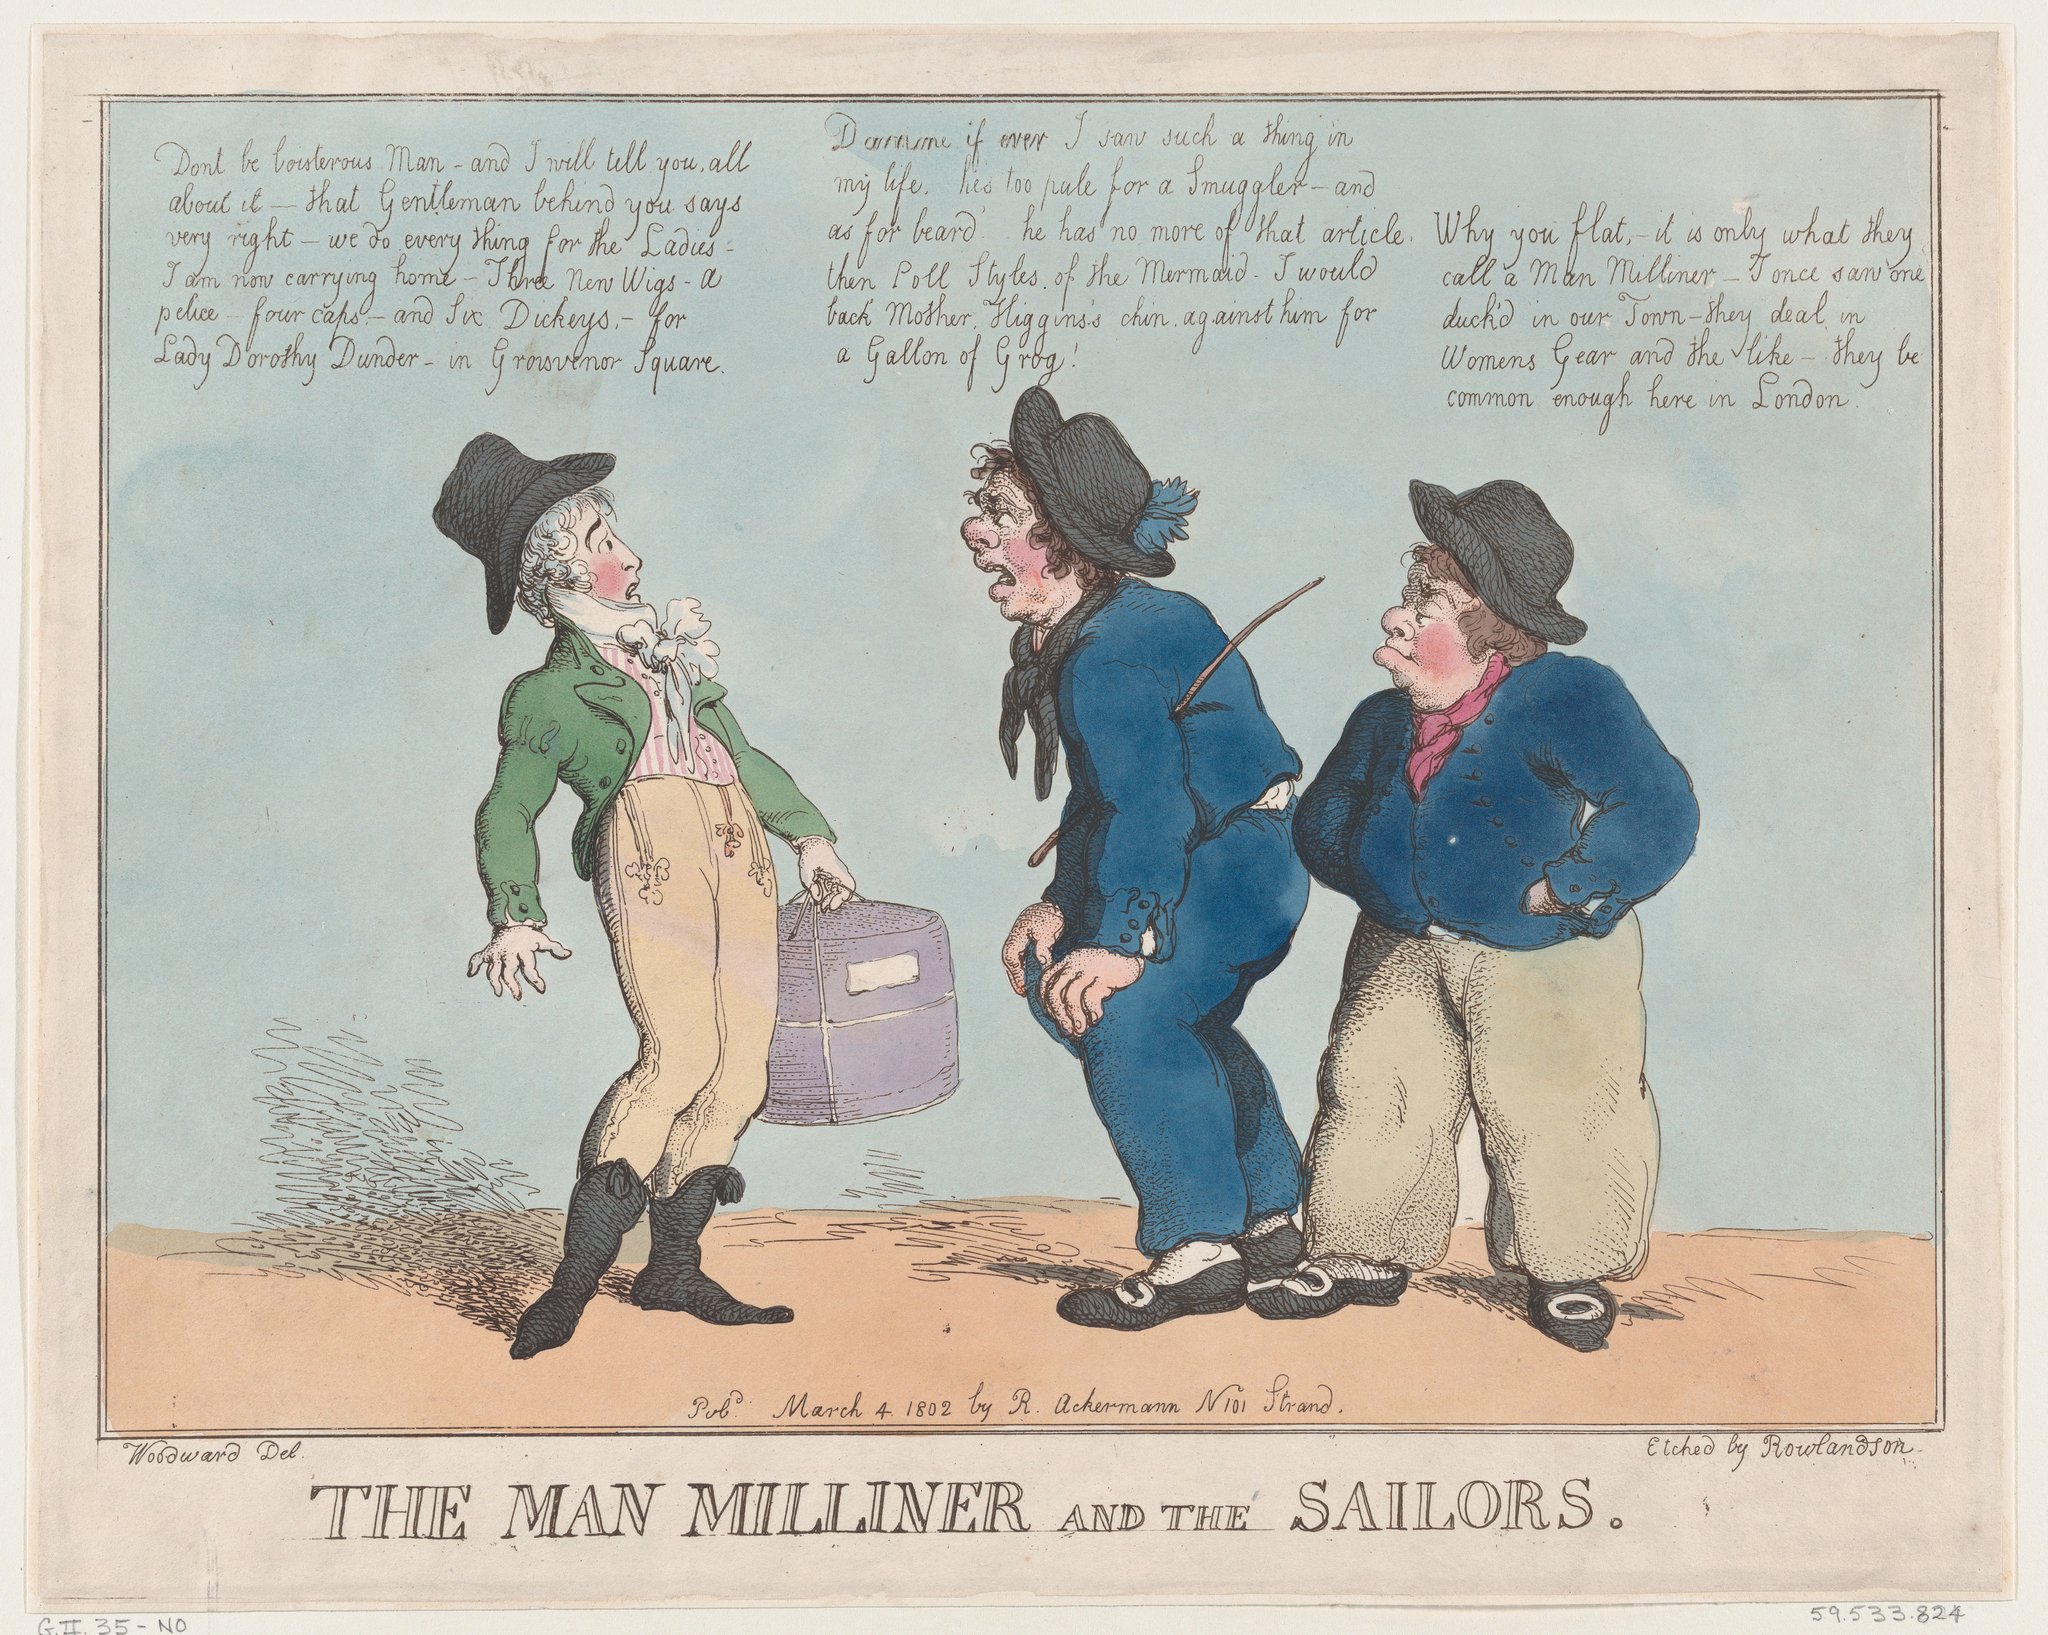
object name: print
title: The Man Milliner and the Sailors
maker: thomas rowlandson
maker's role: artist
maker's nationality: british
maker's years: 1757-1827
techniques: etching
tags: men,sailors